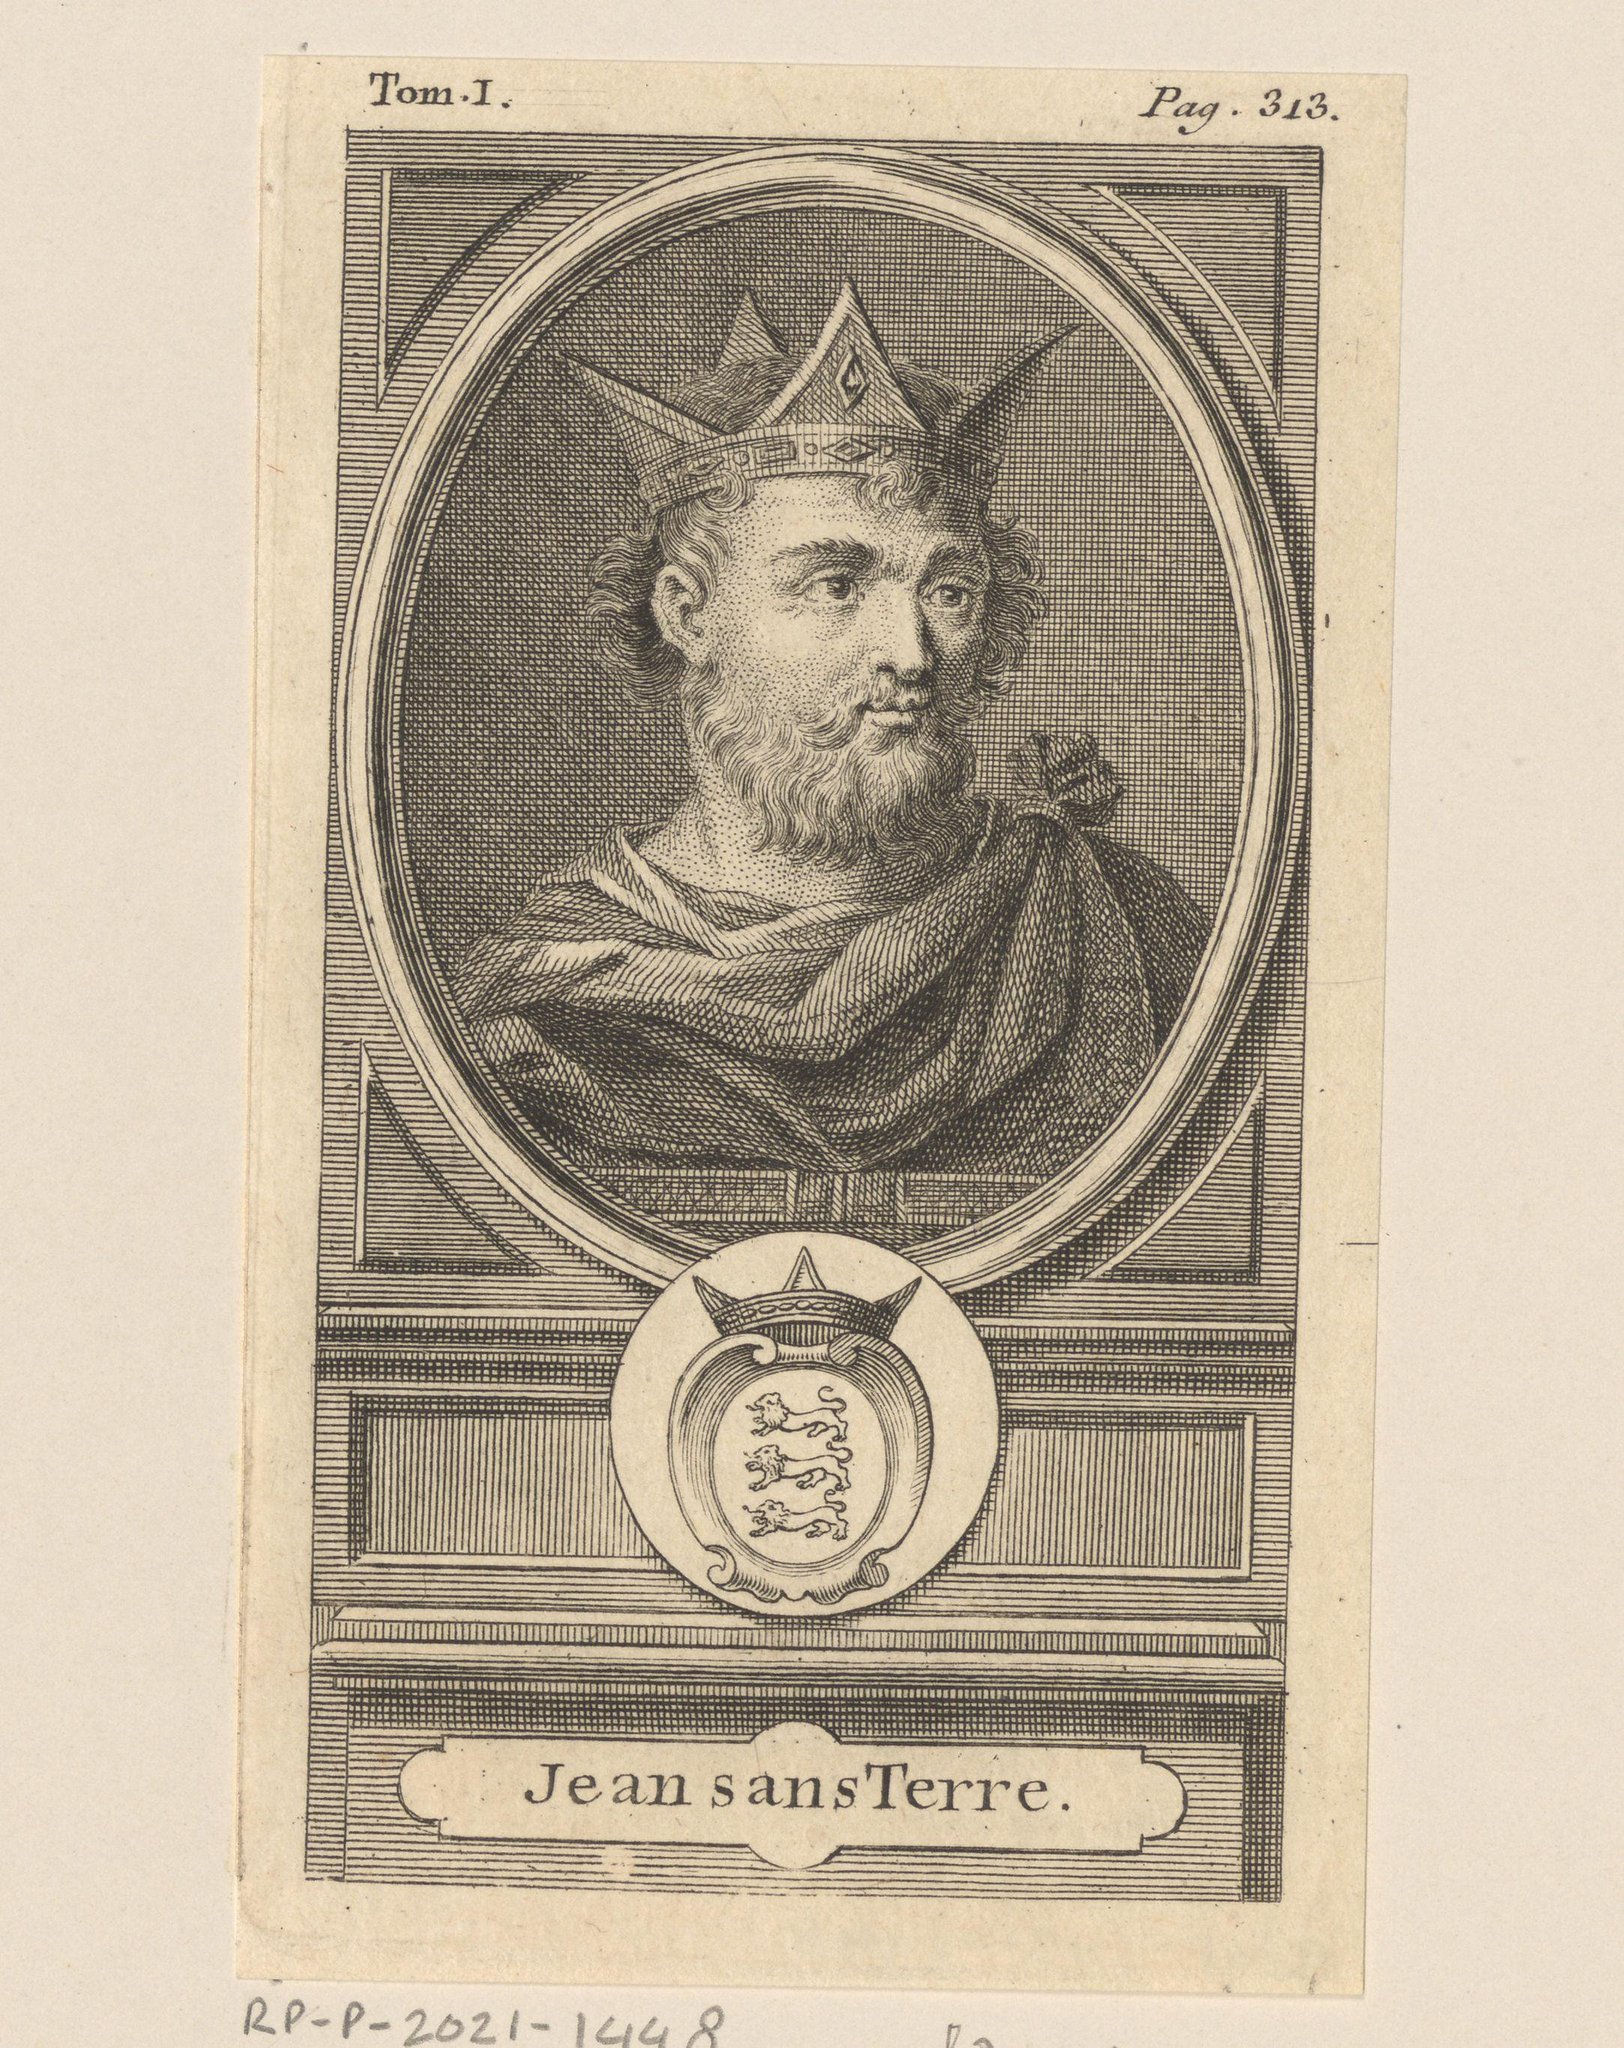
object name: print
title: Portret van Jan zonder Land, koning van Engeland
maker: Anonymous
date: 1700-1799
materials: paper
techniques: engraving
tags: historical persons, king